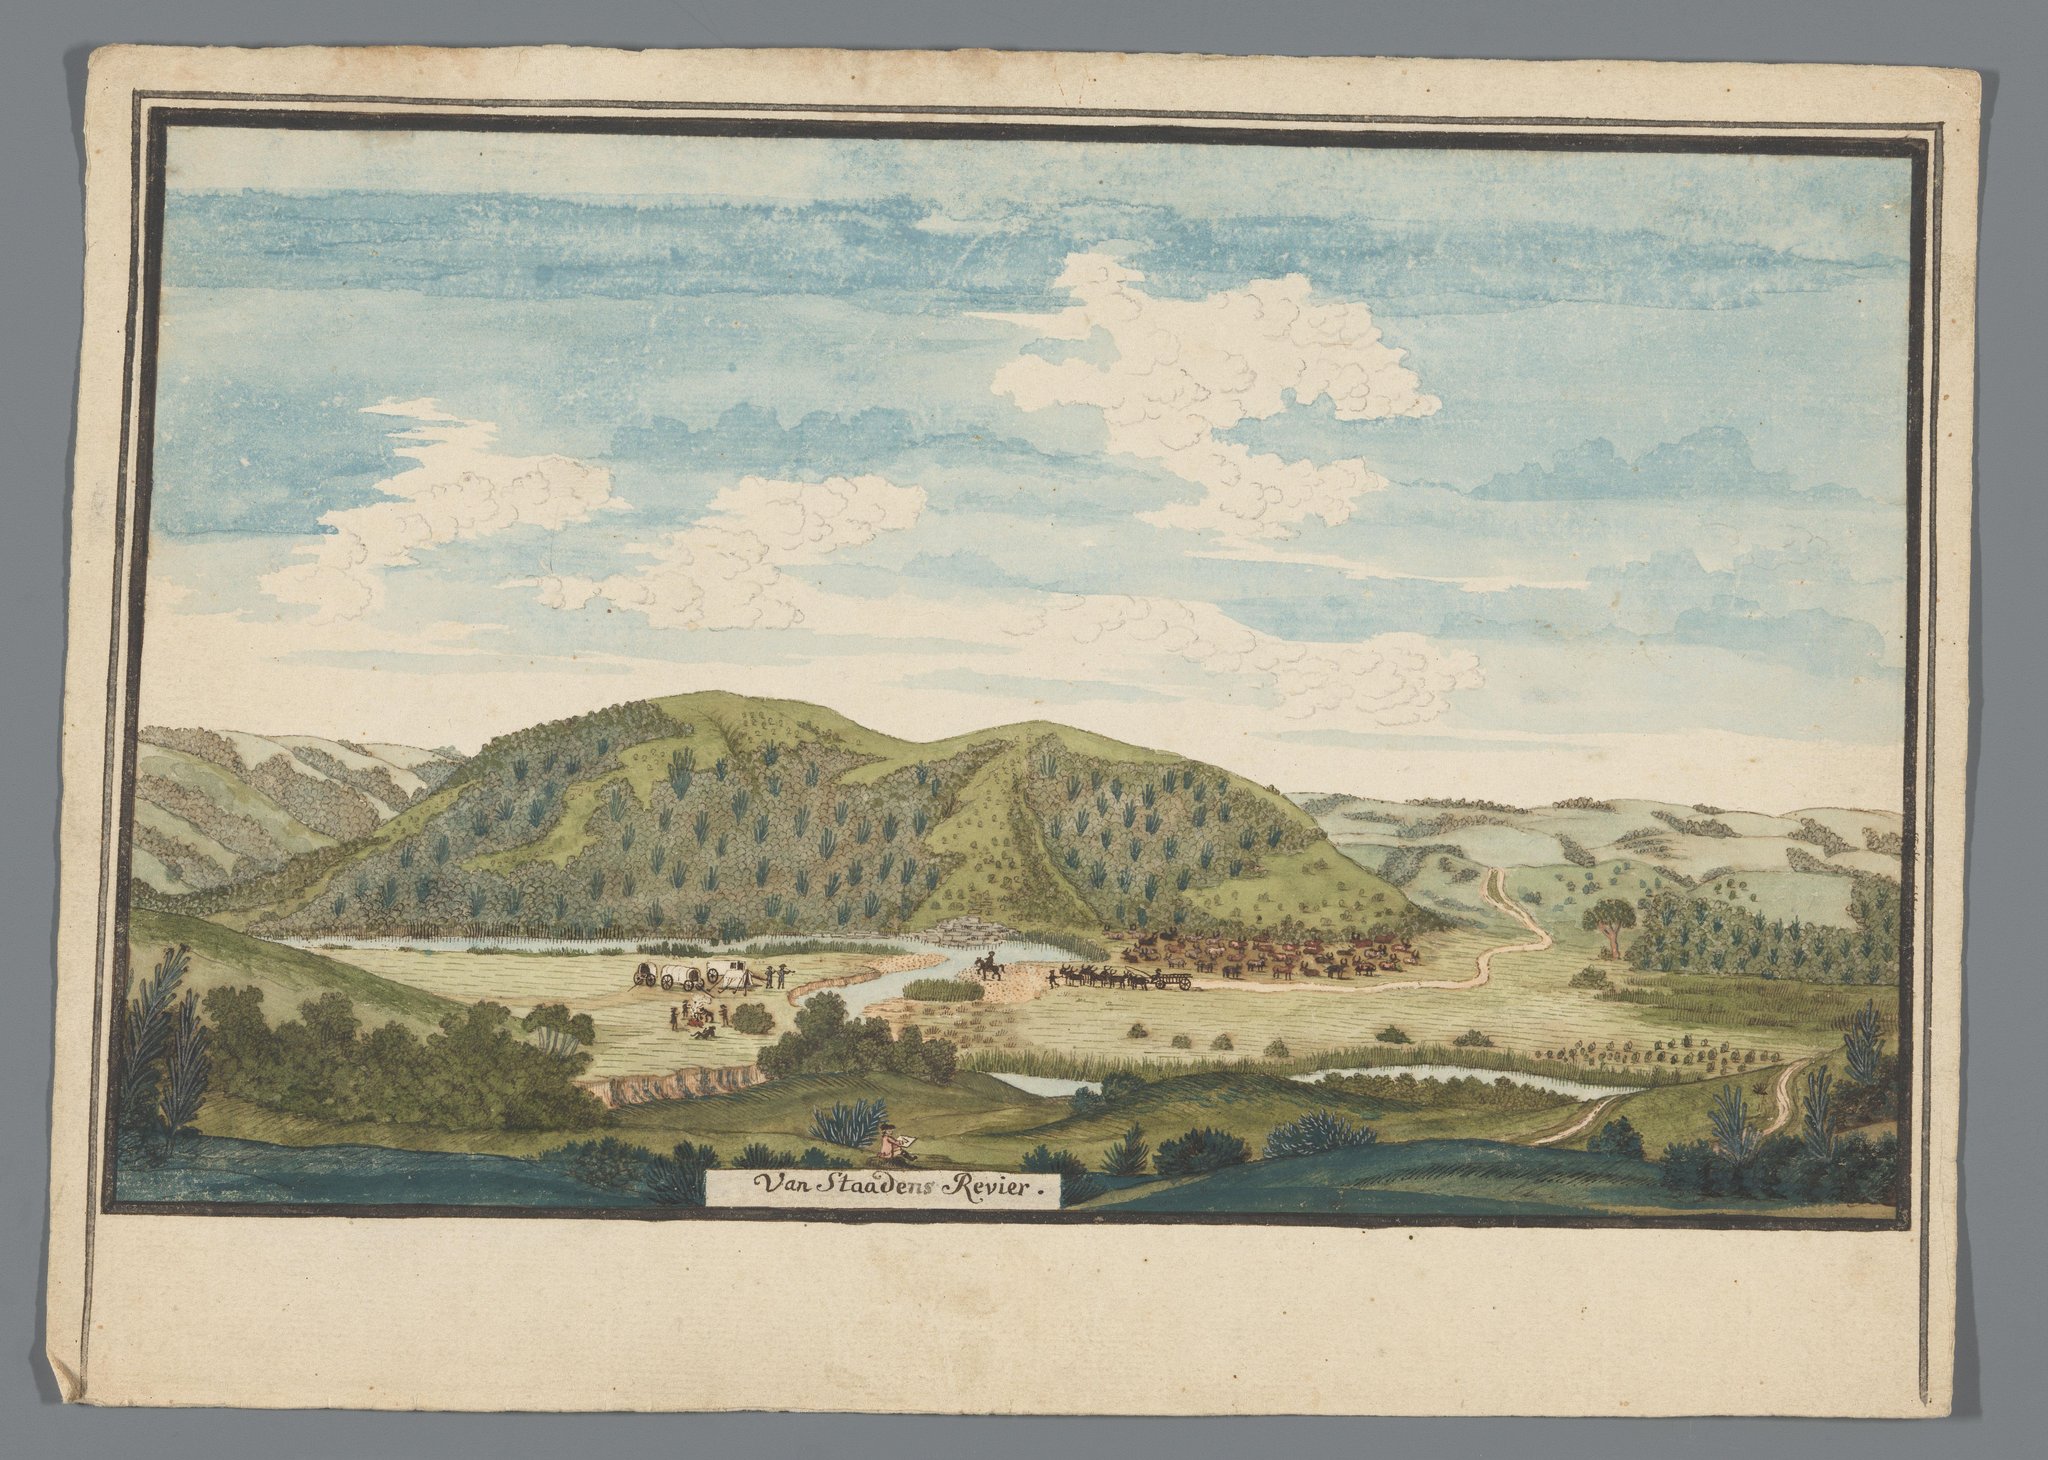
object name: drawing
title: De Van Stadensrivier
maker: johannes schumacher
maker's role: draughtsman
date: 1711-1776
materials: paper, watercolor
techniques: brush, pen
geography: south africa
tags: cape of good hope, tent, river, camp-fire; watch-fire, covered wagon, hooded wagon, draughtsman at work - cc - out of doors, mountains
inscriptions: label: ‘13’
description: Bivak bij de benedenloop van de Van Stadensrivier. Links de wagens, tent en kampvuur, rechts een ossenwagen en een kudde vee. Op de voorgrond is de tekenaar Schumacher aan het werk. Tekening gemaakt tijdens de tweede reis van Hendrik Swellengrebel, naar het noordoosten van de Kaapkolonie, 10 september - 26 december 1776. Volgens het reisjournaal arrriveert het gezelschap op 18 november 1776 bij de rivier.